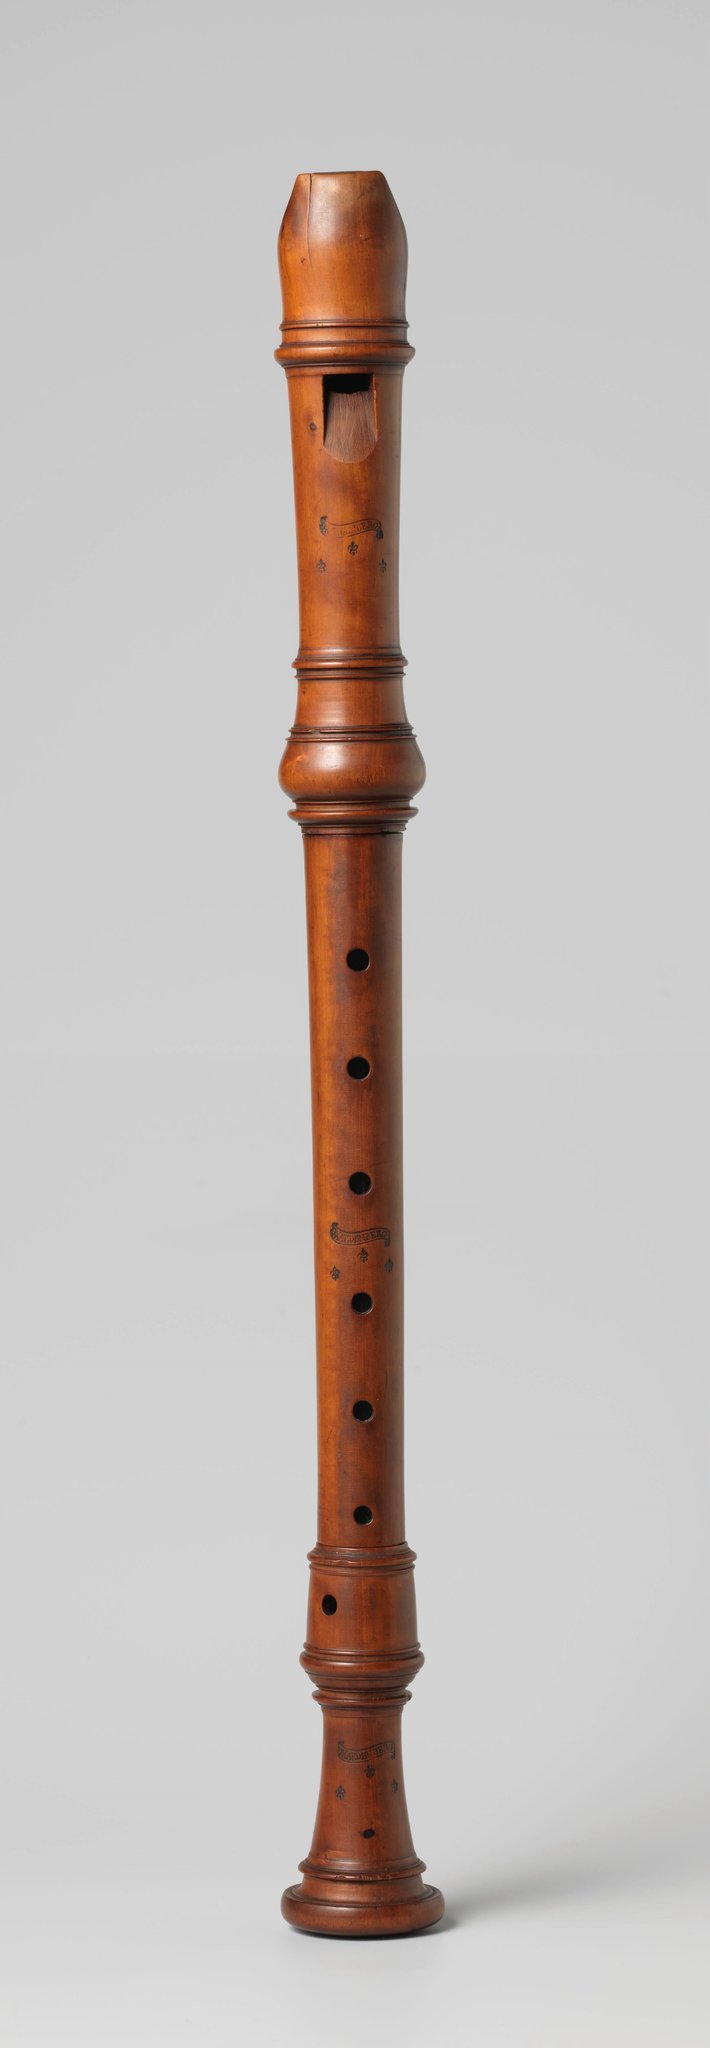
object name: alto recorder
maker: abraham van aardenberg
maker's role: musical instrument maker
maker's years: 1672-1717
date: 1700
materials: wood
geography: amsterdam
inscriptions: mark, on the upper, main and foot joint, stamped: ‘V AARDENBERG’ AARDENBERG [in scroll with a high V in the first A of the name]/ three fleurs-de-lis